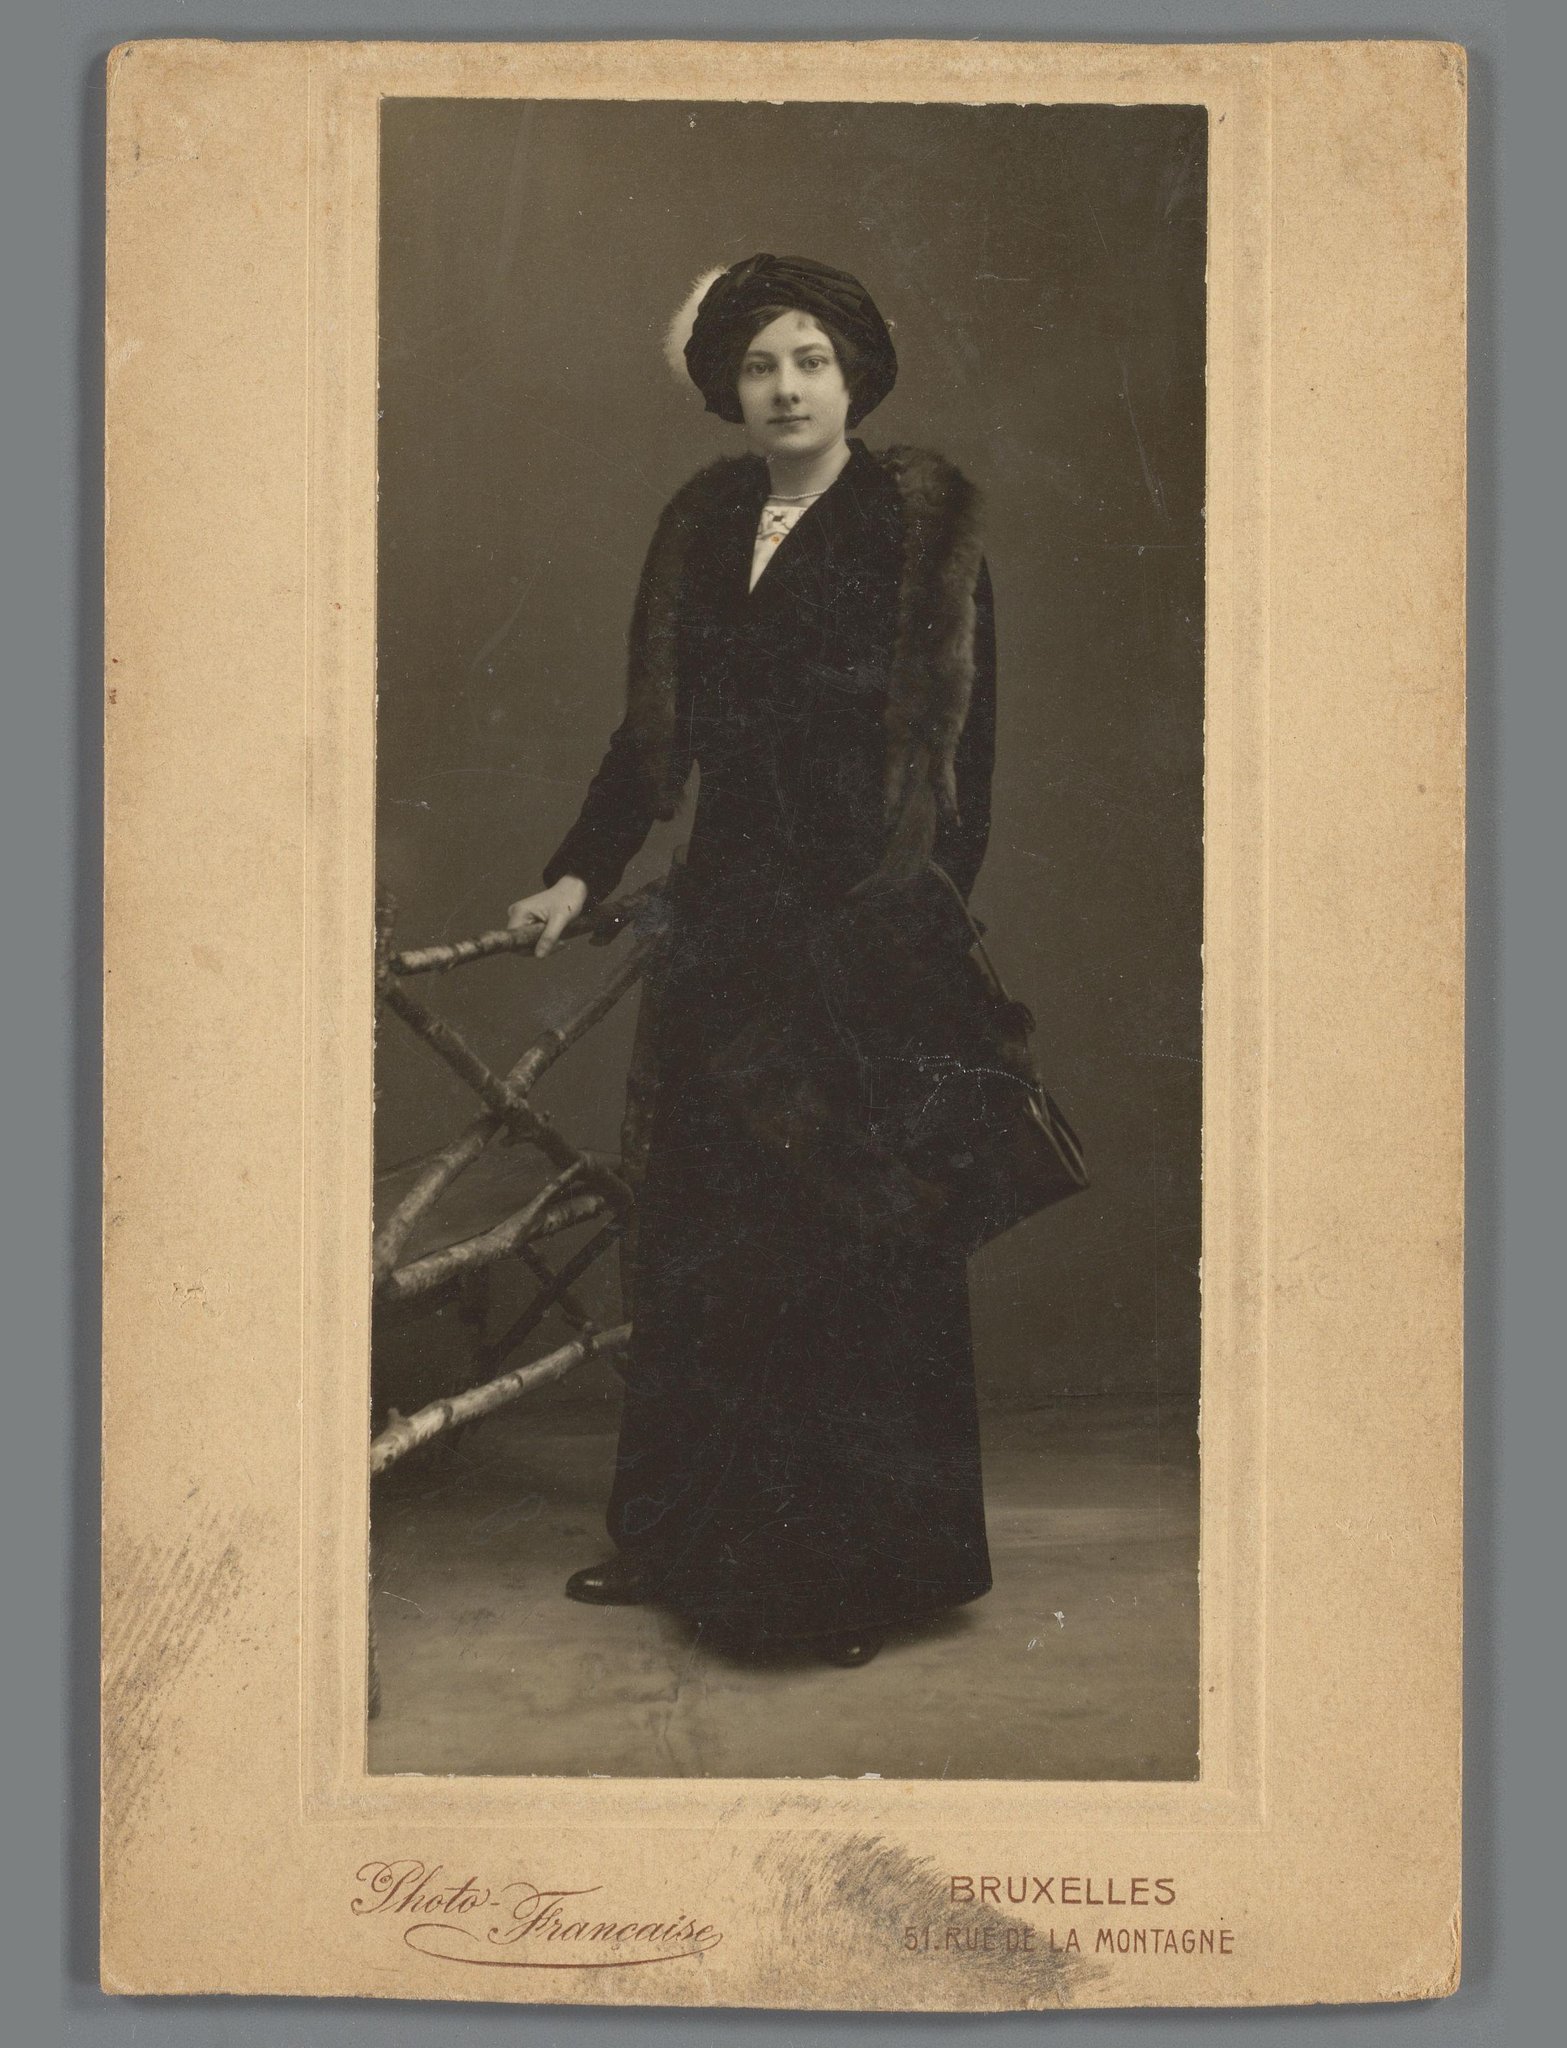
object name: cabinet photograph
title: Portret van een onbekende vrouw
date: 1900-1920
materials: cardboard, photographic support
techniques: gelatin silver print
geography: brussels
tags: historical persons - bb - woman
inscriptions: inscription: ‘Photo- Française/ BRUXELLES/ 51. RUE DE LA MONTAGNE’